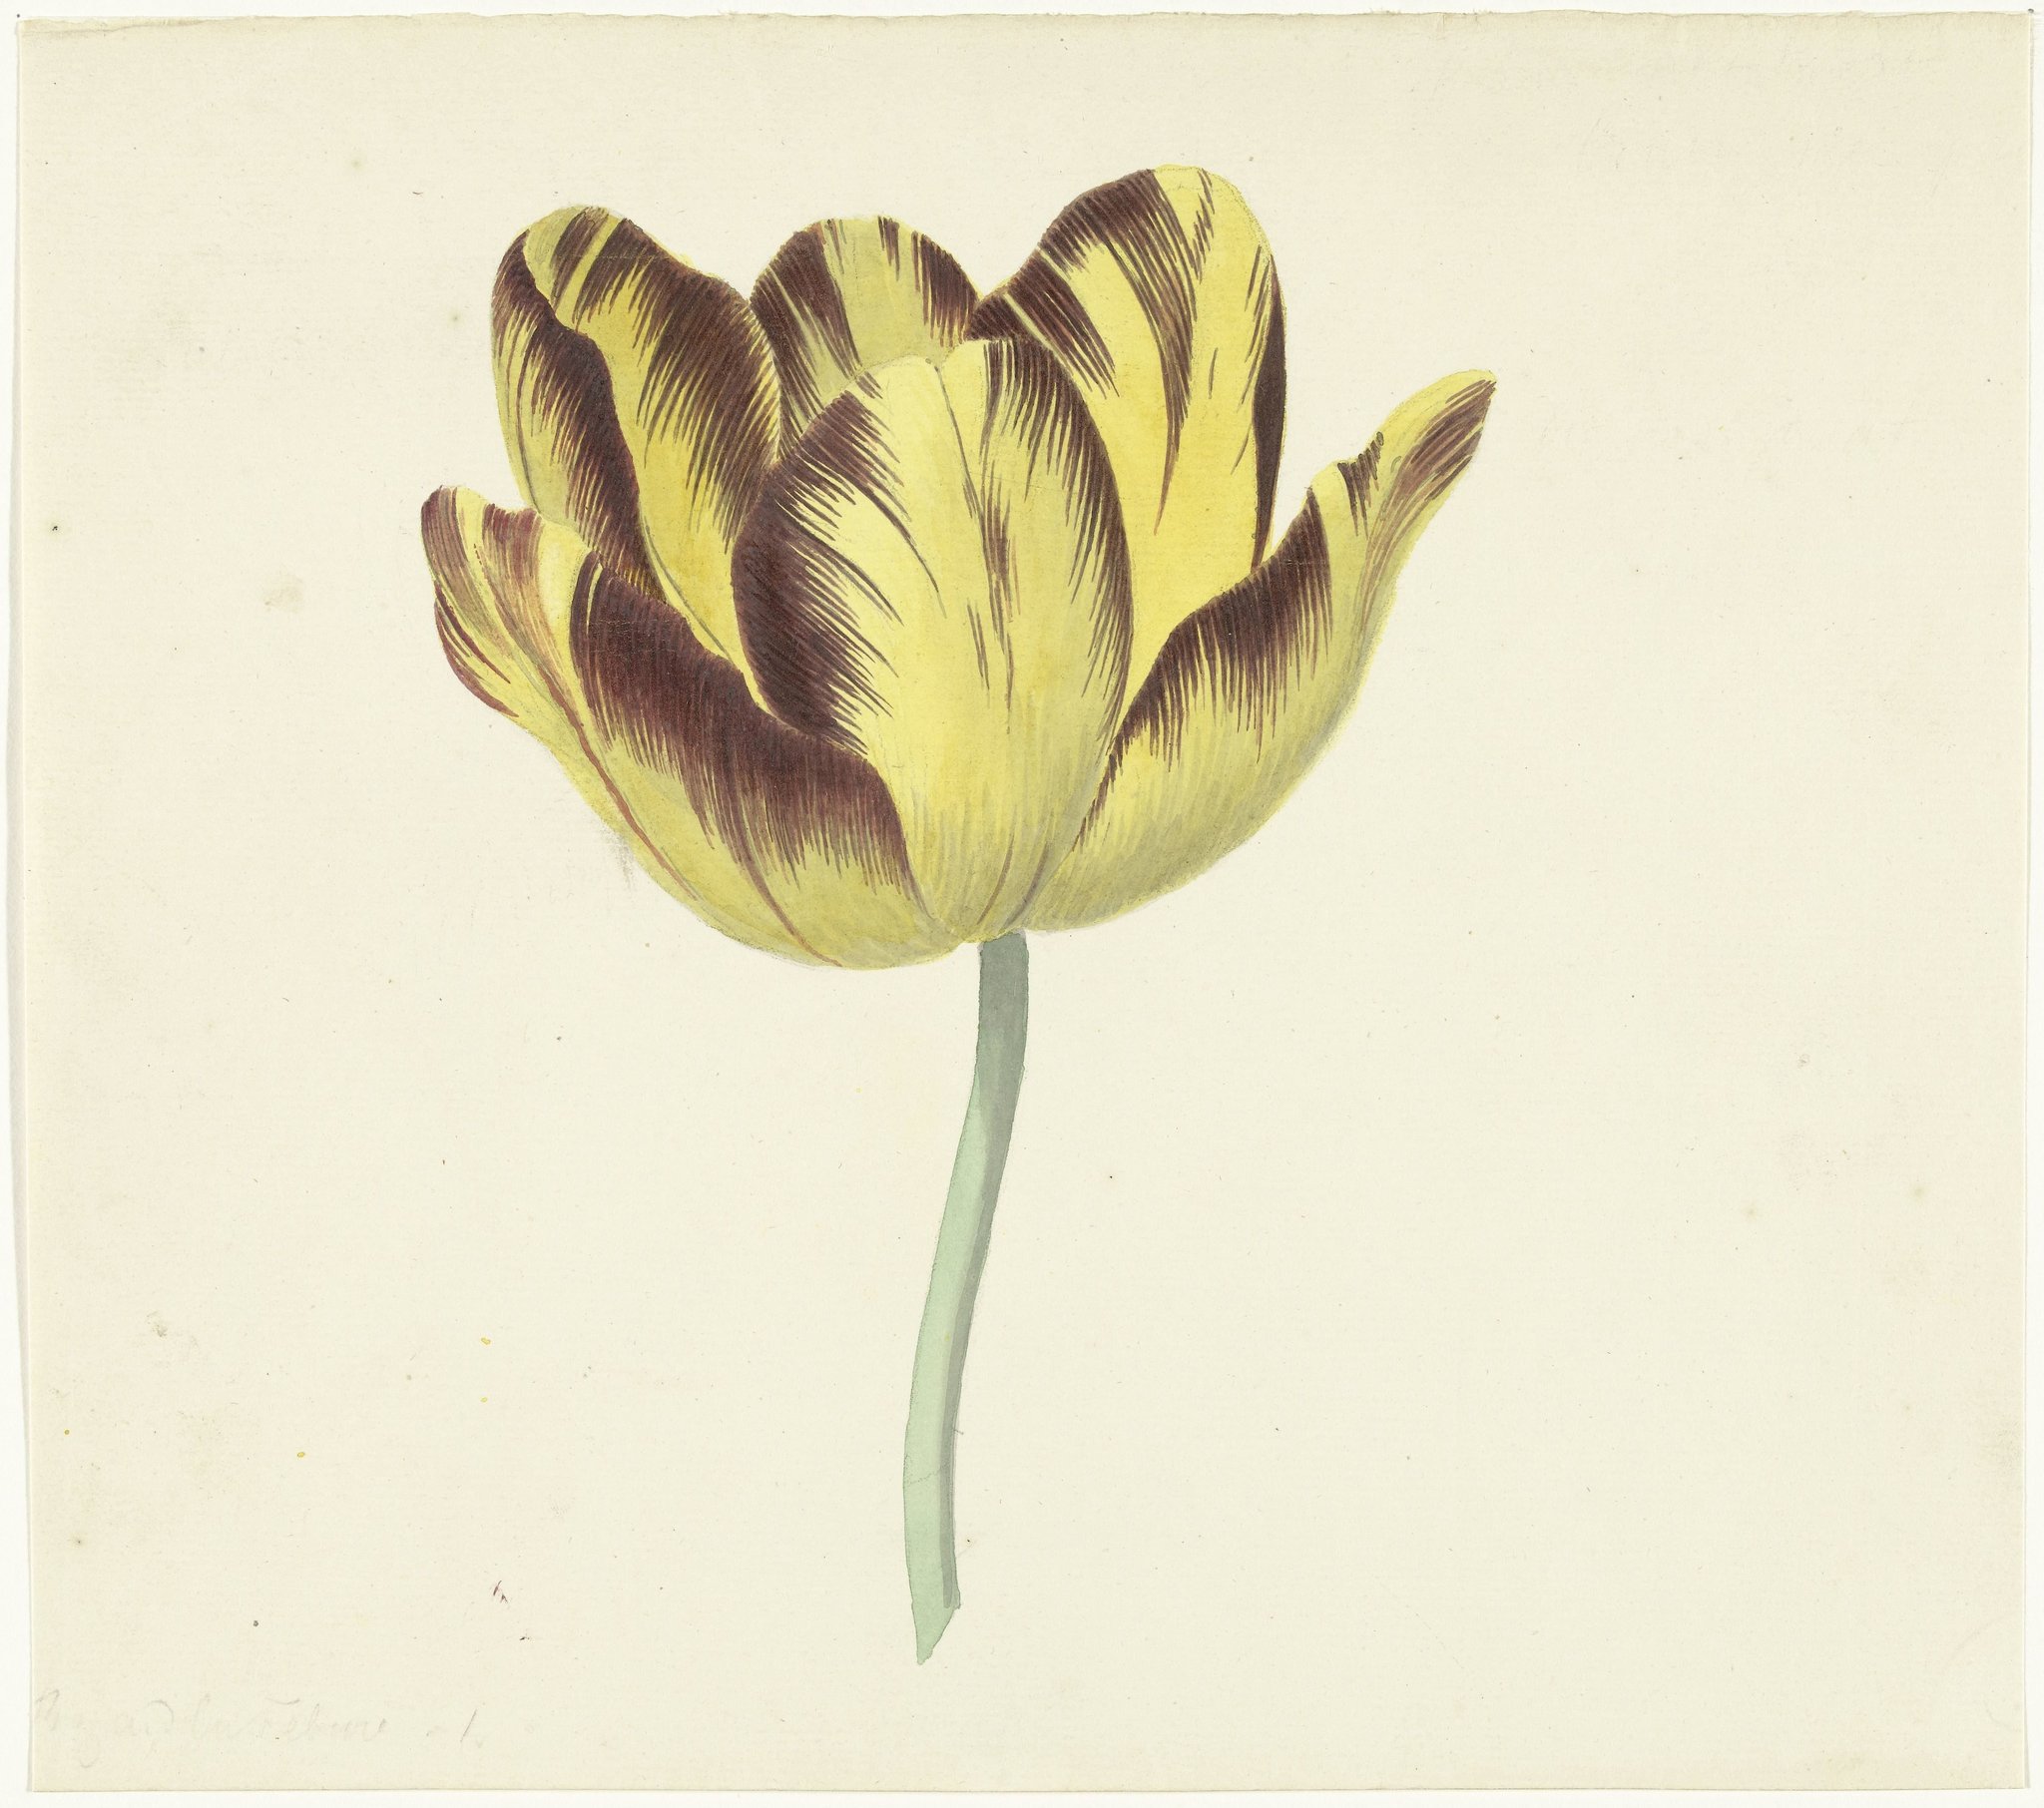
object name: drawing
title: Tulp genaamd Bizard Le Febure No. 1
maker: cornelis van noorde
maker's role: draughtsman, print maker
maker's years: 1731-1795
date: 1741-1795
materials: chalk, paper, watercolor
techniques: brush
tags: flowers: tulip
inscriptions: inscription: ‘Bizard Le Febure No. 1’